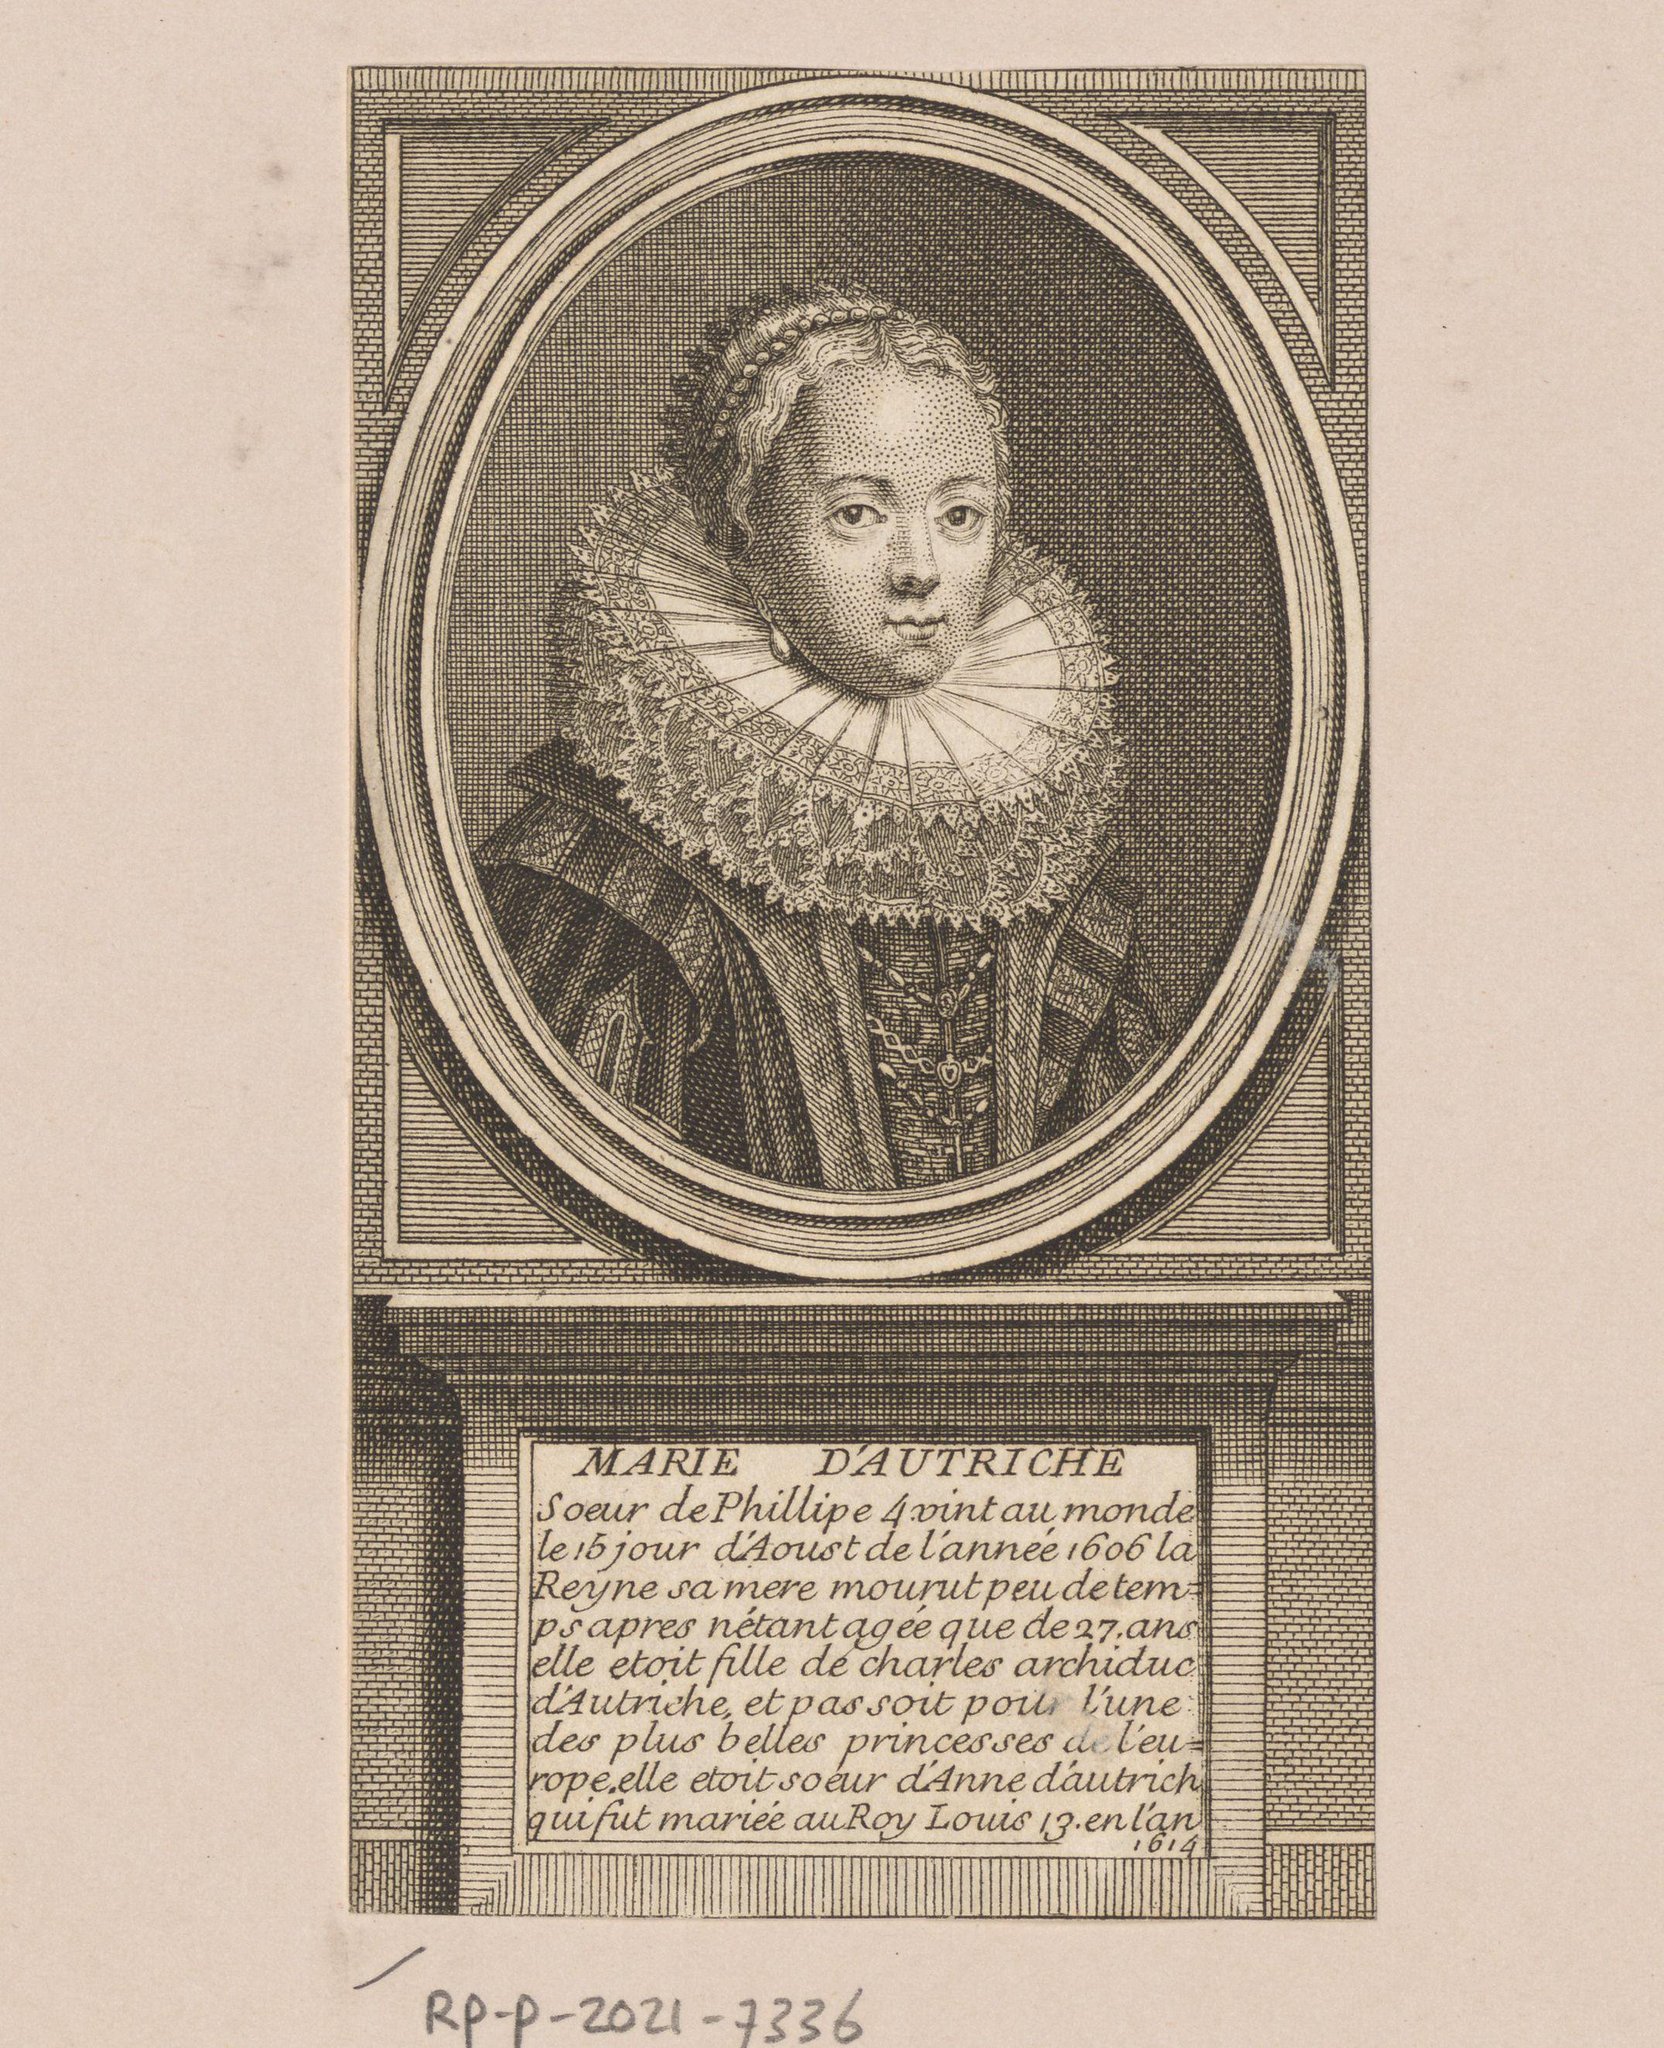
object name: print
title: Portret van Maria Anna van Oostenrijk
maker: Anonymous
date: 1723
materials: paper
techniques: engraving, etching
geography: france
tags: historical persons - bb - woman, ornament ~ medallion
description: Prent waarschijnlijk uit: Histoire Generale d'Espagne (...). Parijs: Theodore Le Gras, 1723, dl. 8, p. 30.